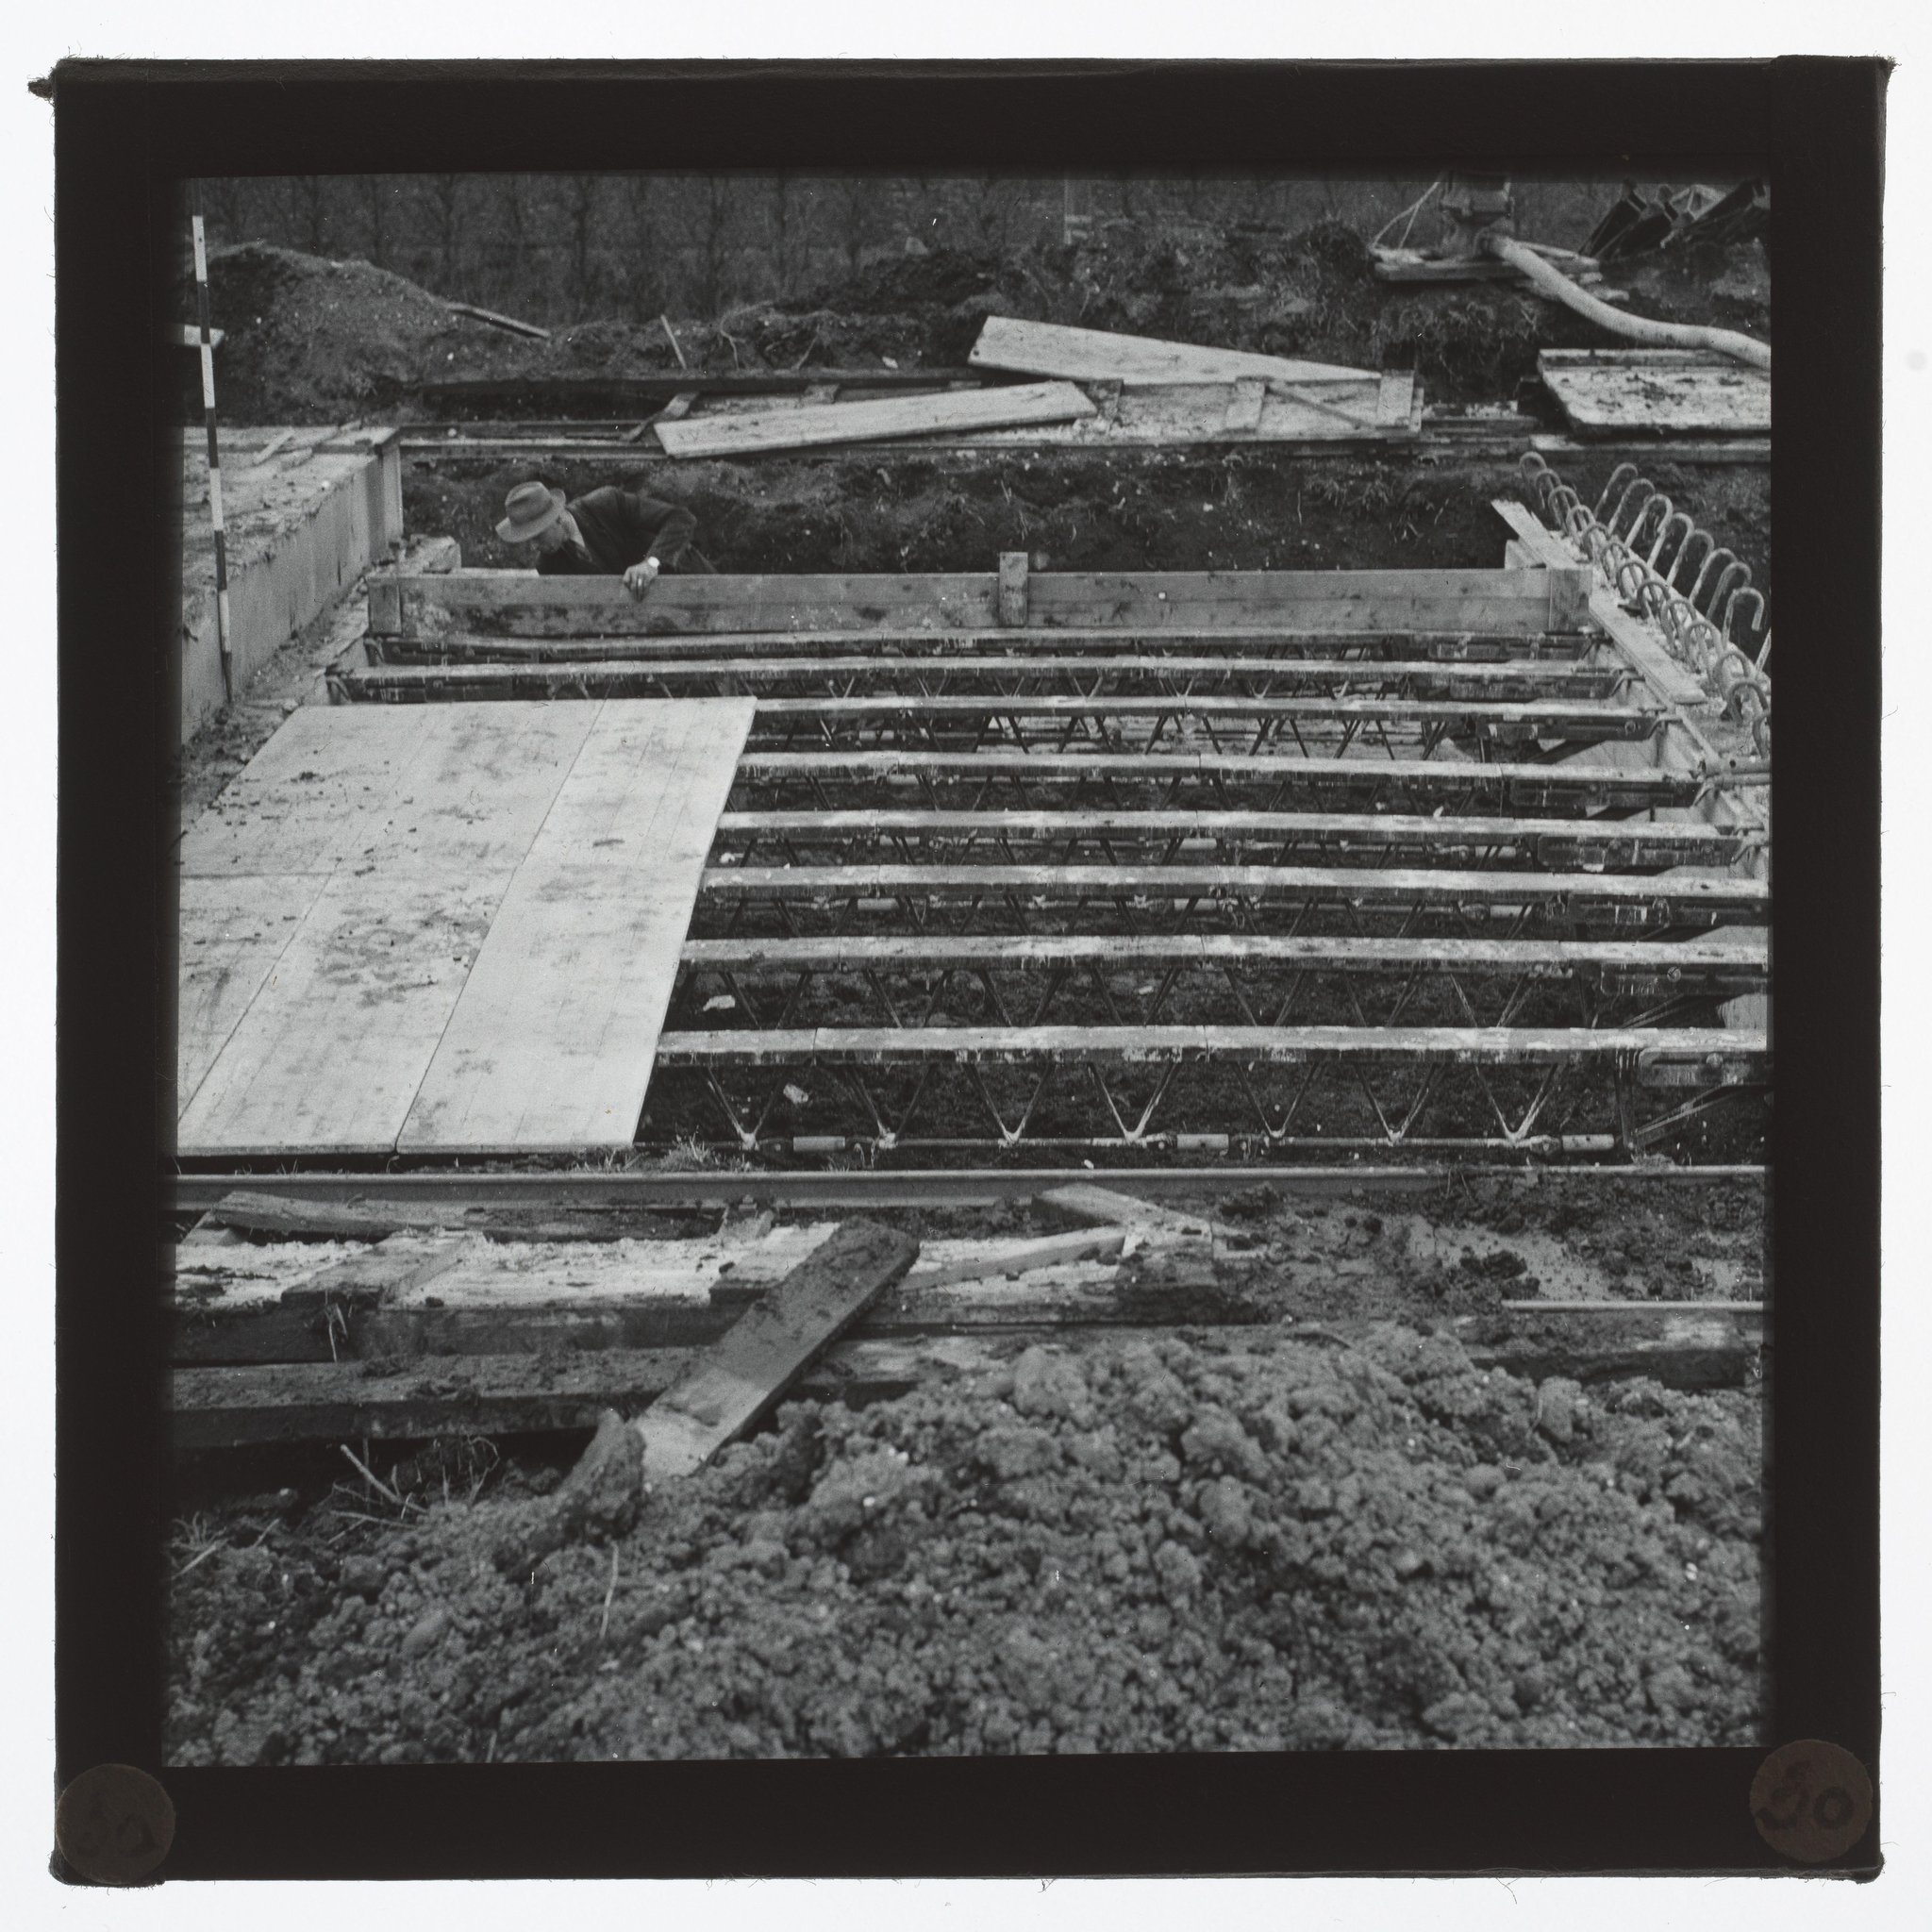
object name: lantern slide photographic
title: Bouwplaats, Zuid-Holland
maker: Anonymous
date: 1956-1960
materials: glass, paper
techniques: gelatin silver transparency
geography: south holland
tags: building-site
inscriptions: number: ‘30’